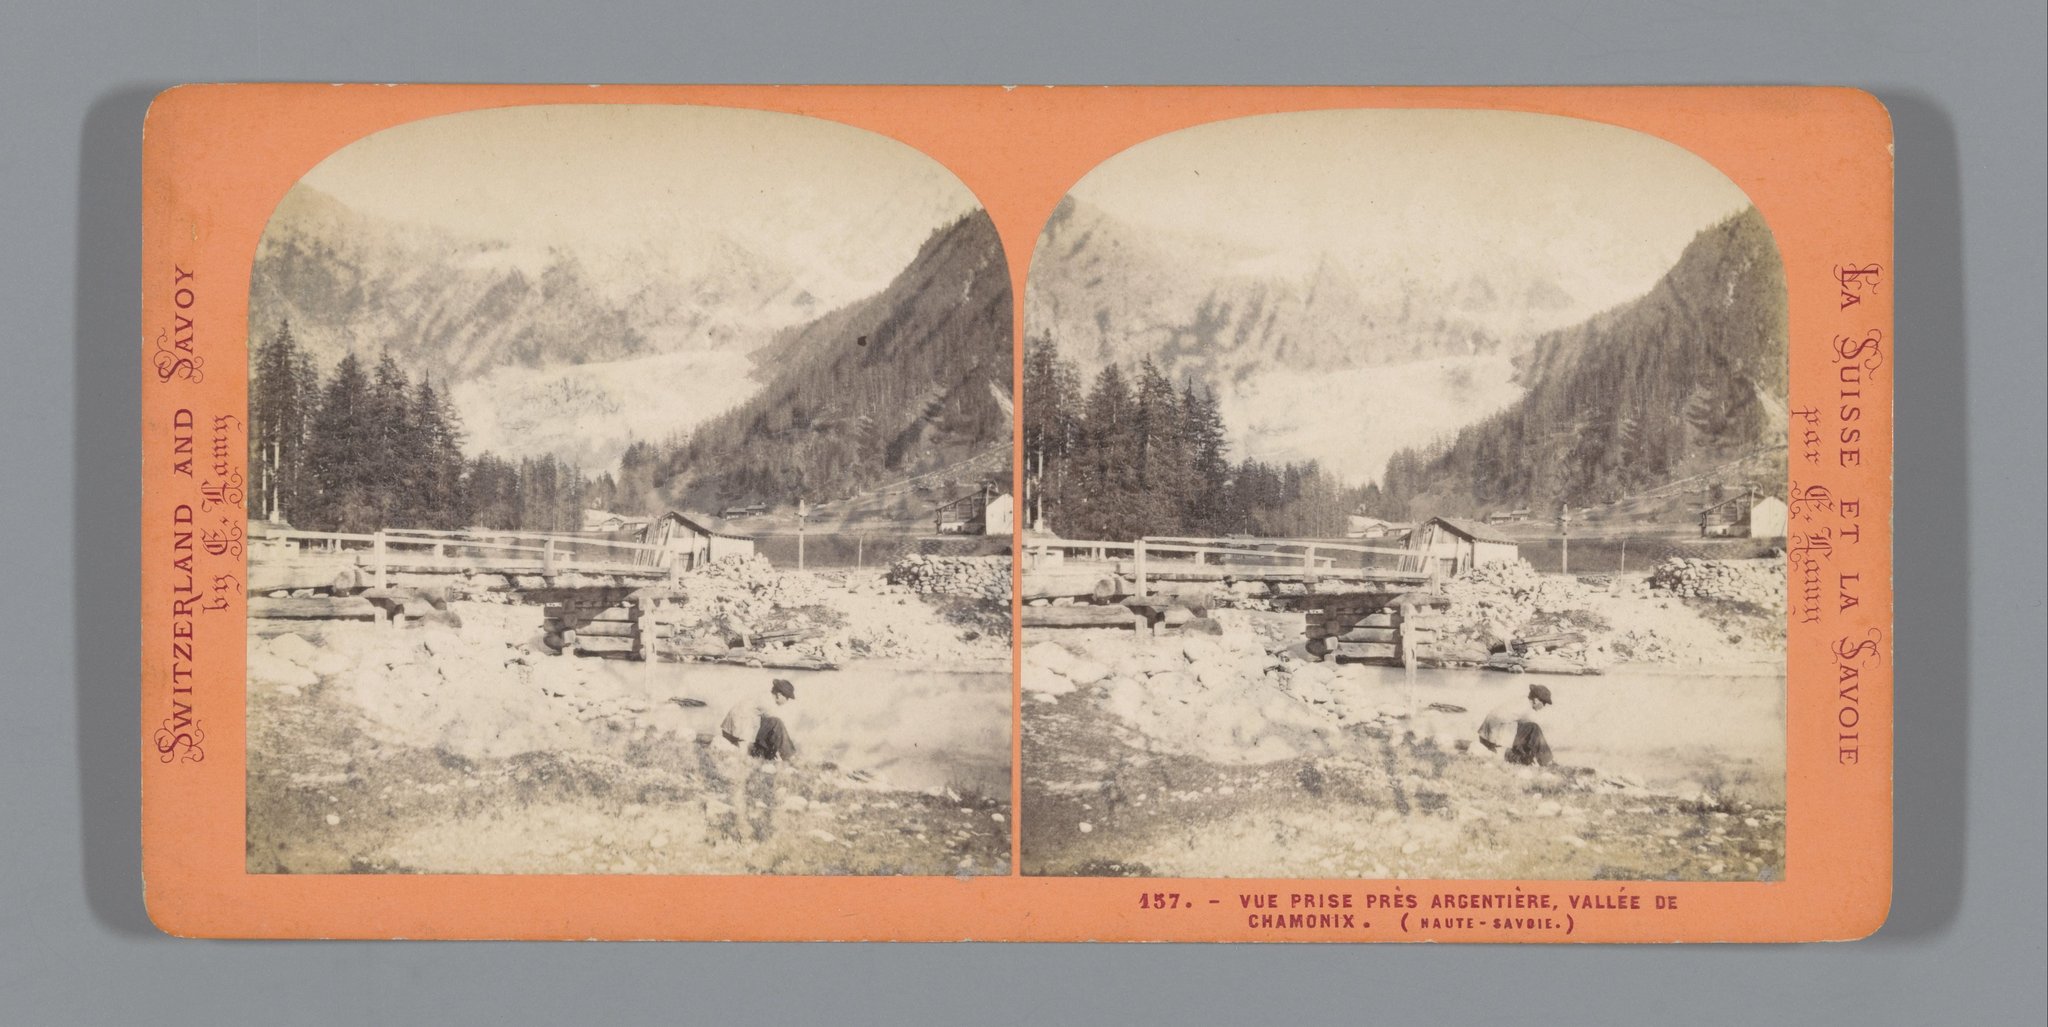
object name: stereograph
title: Gezicht op de vallei van Chamonix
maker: ernest eléonor pierre lamy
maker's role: publisher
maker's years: 1828-1900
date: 1860-1880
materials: cardboard, photographic support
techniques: albumen print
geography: chamonix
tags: dale, valley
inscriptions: number: ‘157.’